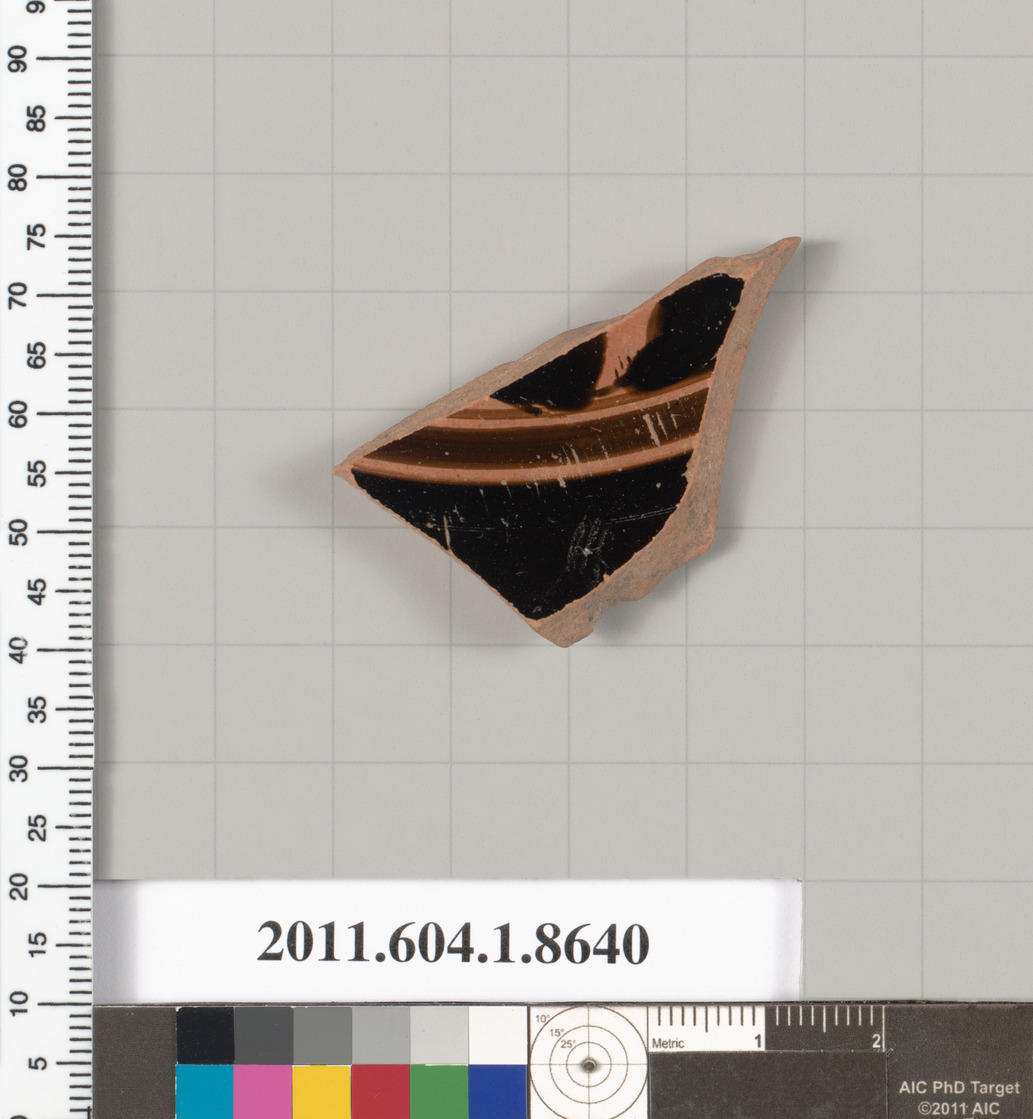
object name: kylix fragment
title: Terracotta fragment of a stemless kylix (drinking cup)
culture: greek, attic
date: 467-435 BCE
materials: terracotta